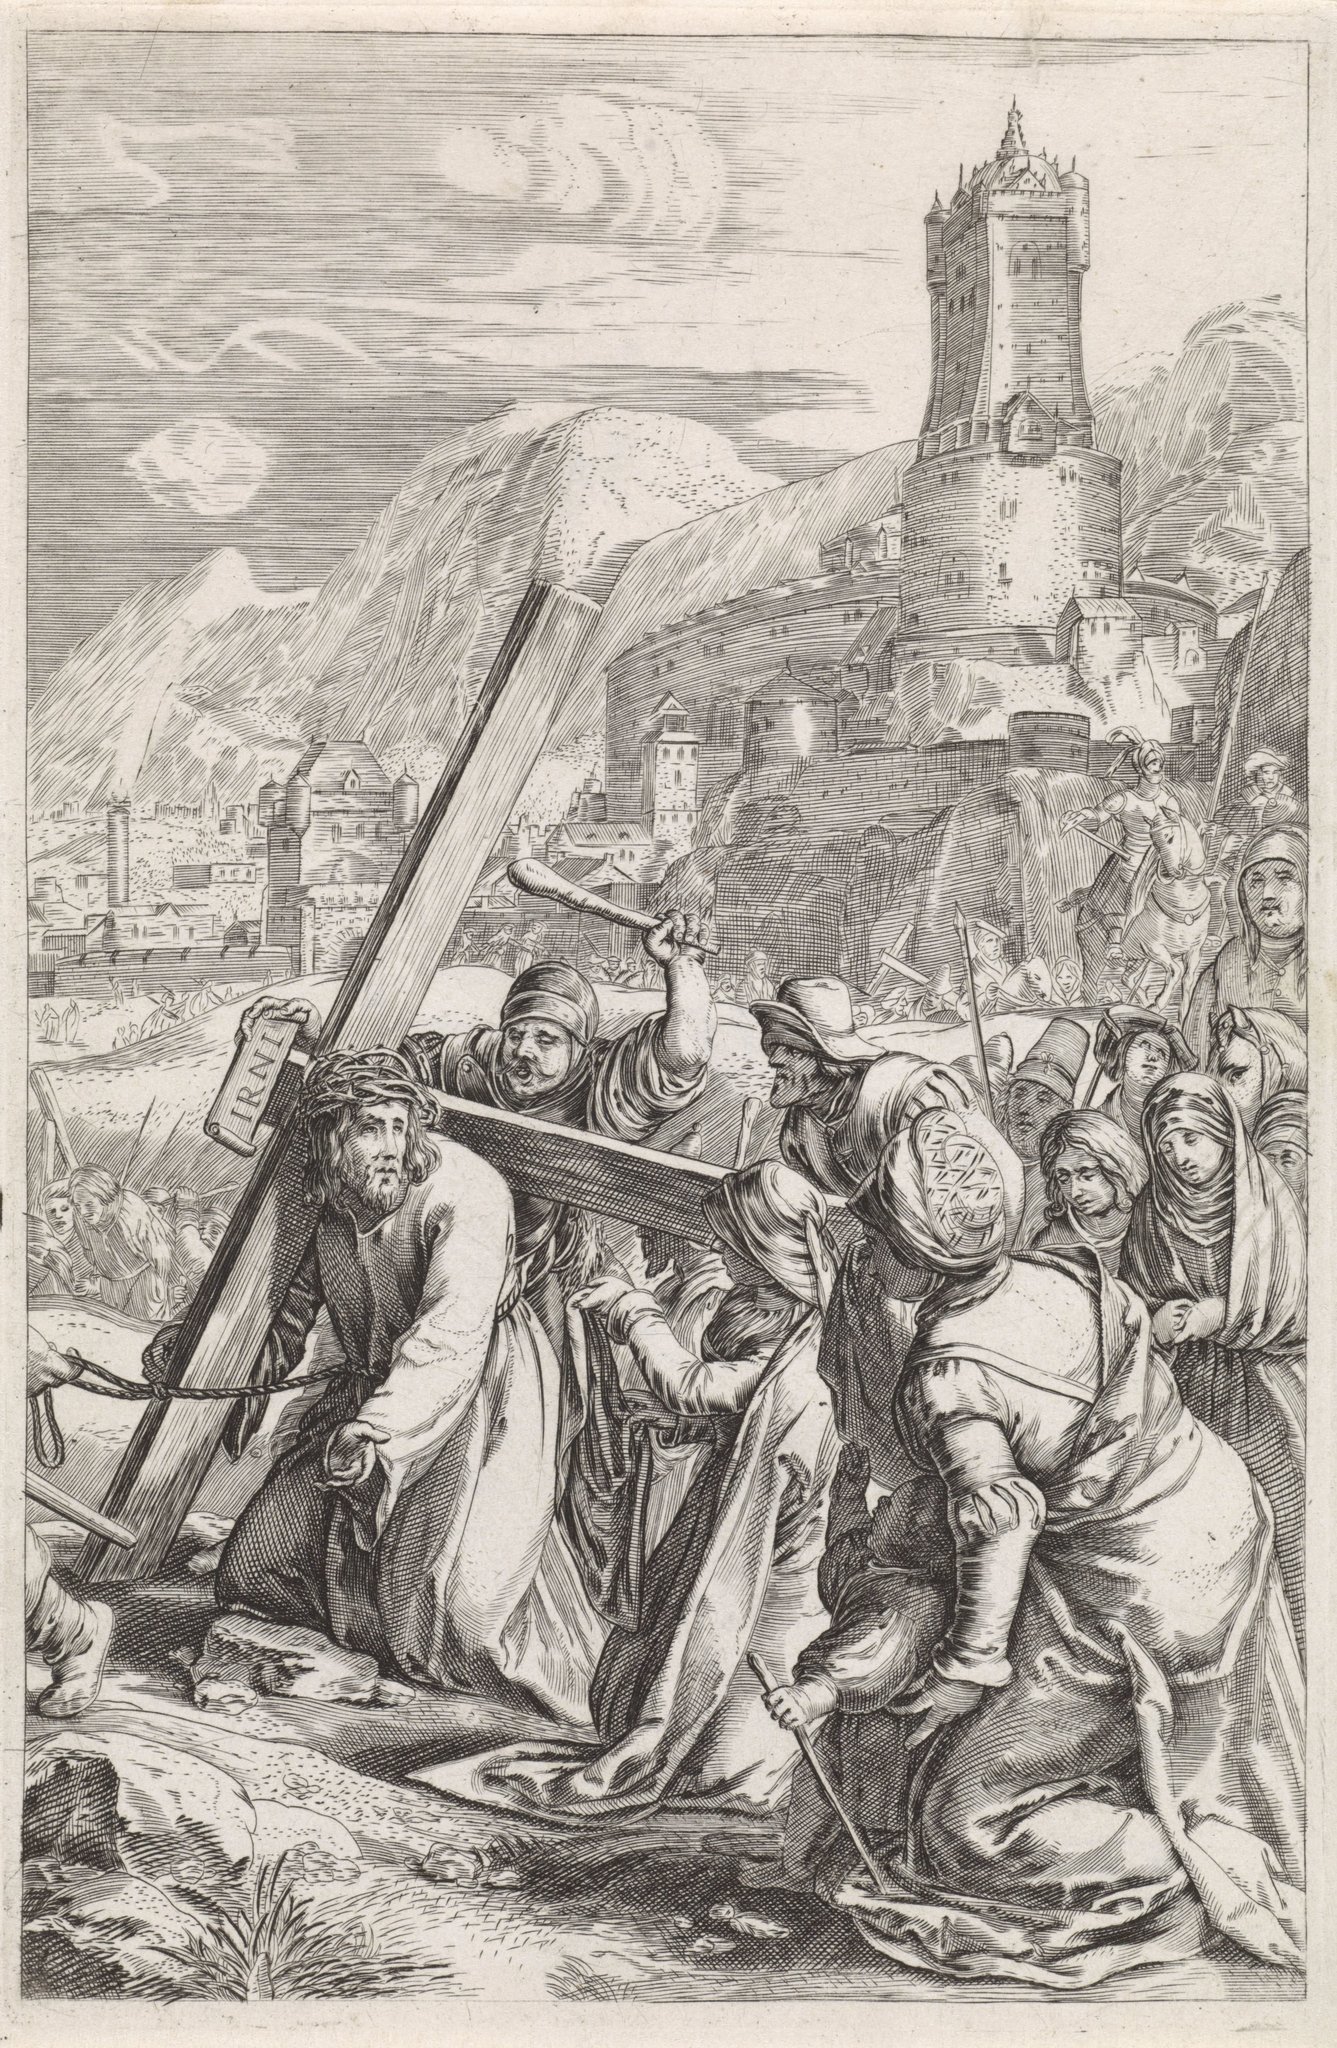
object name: print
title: Kruisdraging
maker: Anonymous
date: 1596-1667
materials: paper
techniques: engraving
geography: netherlands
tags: christ meets veronica, who has a cloth to wipe christ's face, carrying of the cross: christ bearing the cross, alone or with the help of others (e.g. simon the cyrenian)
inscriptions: collector's mark: Lugt 2228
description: Christus draagt het kruis naar Golgota. Veronica knielt naast hem en biedt hem een doek aan. Achter hen de stoet met onder andere Maria en Johannes. Op de achtergrond Jeruzalem.